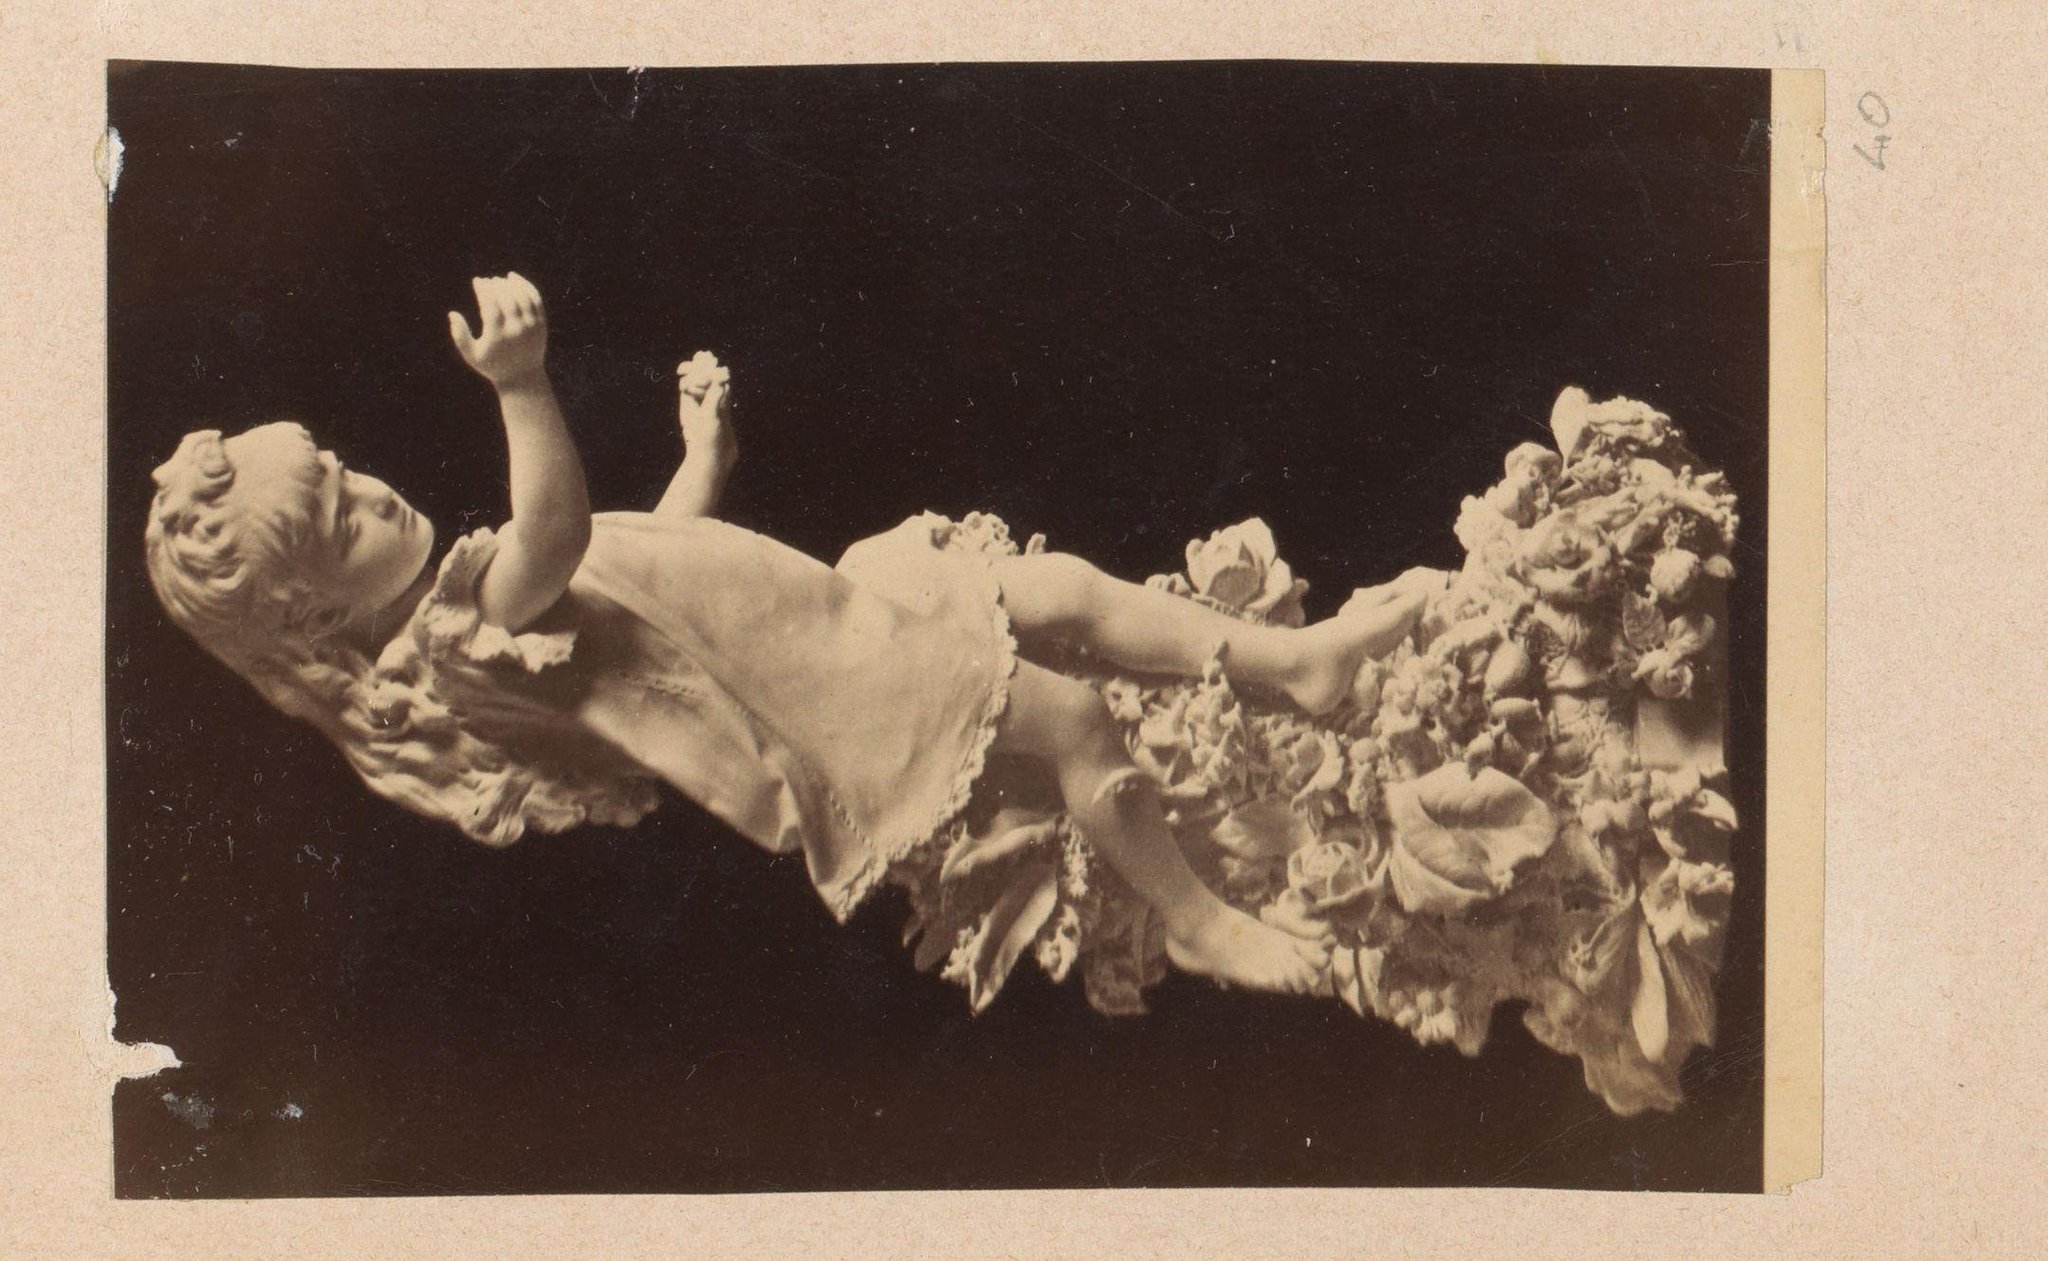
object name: photograph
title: Genova. Camposanto. Monumento. Dapassano. (Costa)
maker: Anonymous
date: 1870-1900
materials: paper, photographic support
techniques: albumen print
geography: genoa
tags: piece of sculpture, reproduction of a piece of sculpture (+ sculpture), grave-building, monumental tomb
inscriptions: negative number: ‘552’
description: Onderdeel van Reisalbum met foto's van bezienswaardigheden in Italië en Zuid-Frankrijk.